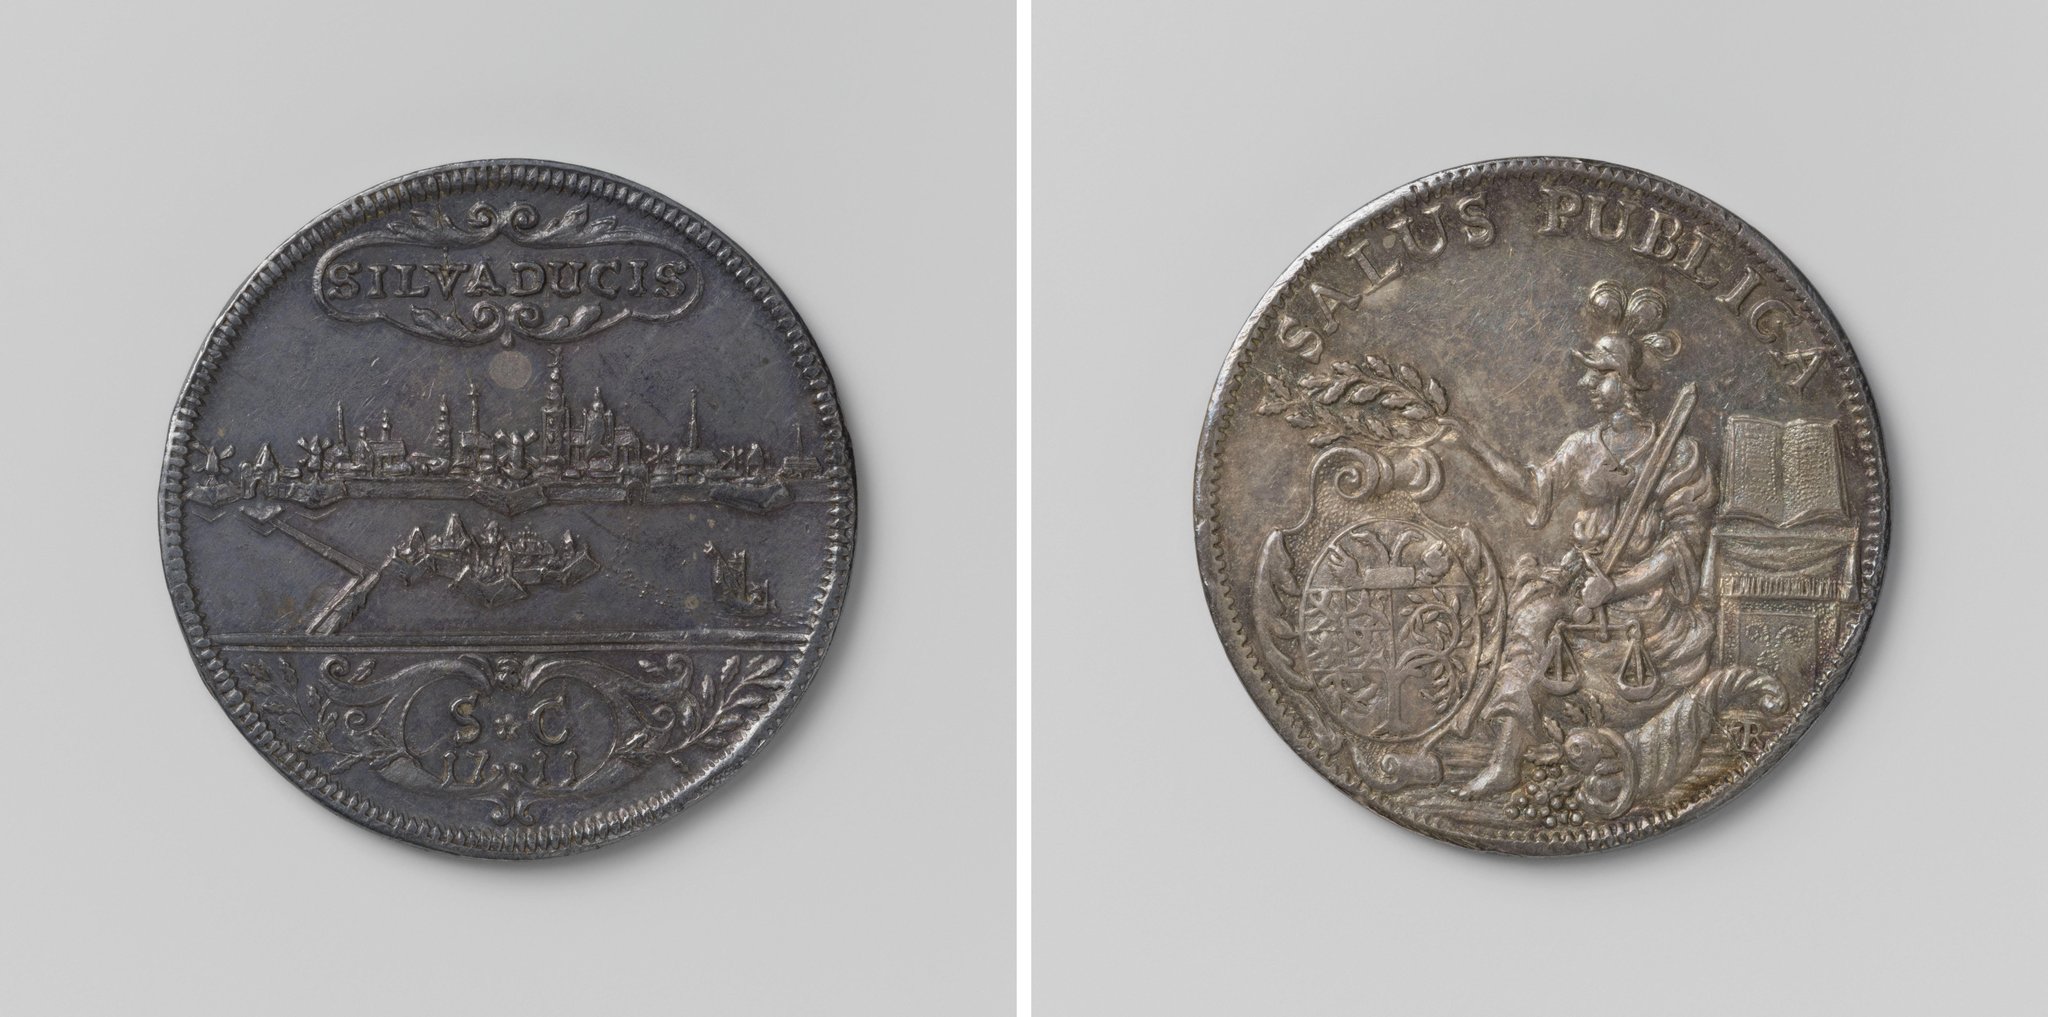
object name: council medal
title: Vroedschapspenning van de stad 's-Hertogenbosch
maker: theodorus casparus van berckel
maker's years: 1680-1734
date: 1711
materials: silver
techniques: striking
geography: den bosch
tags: den bosch